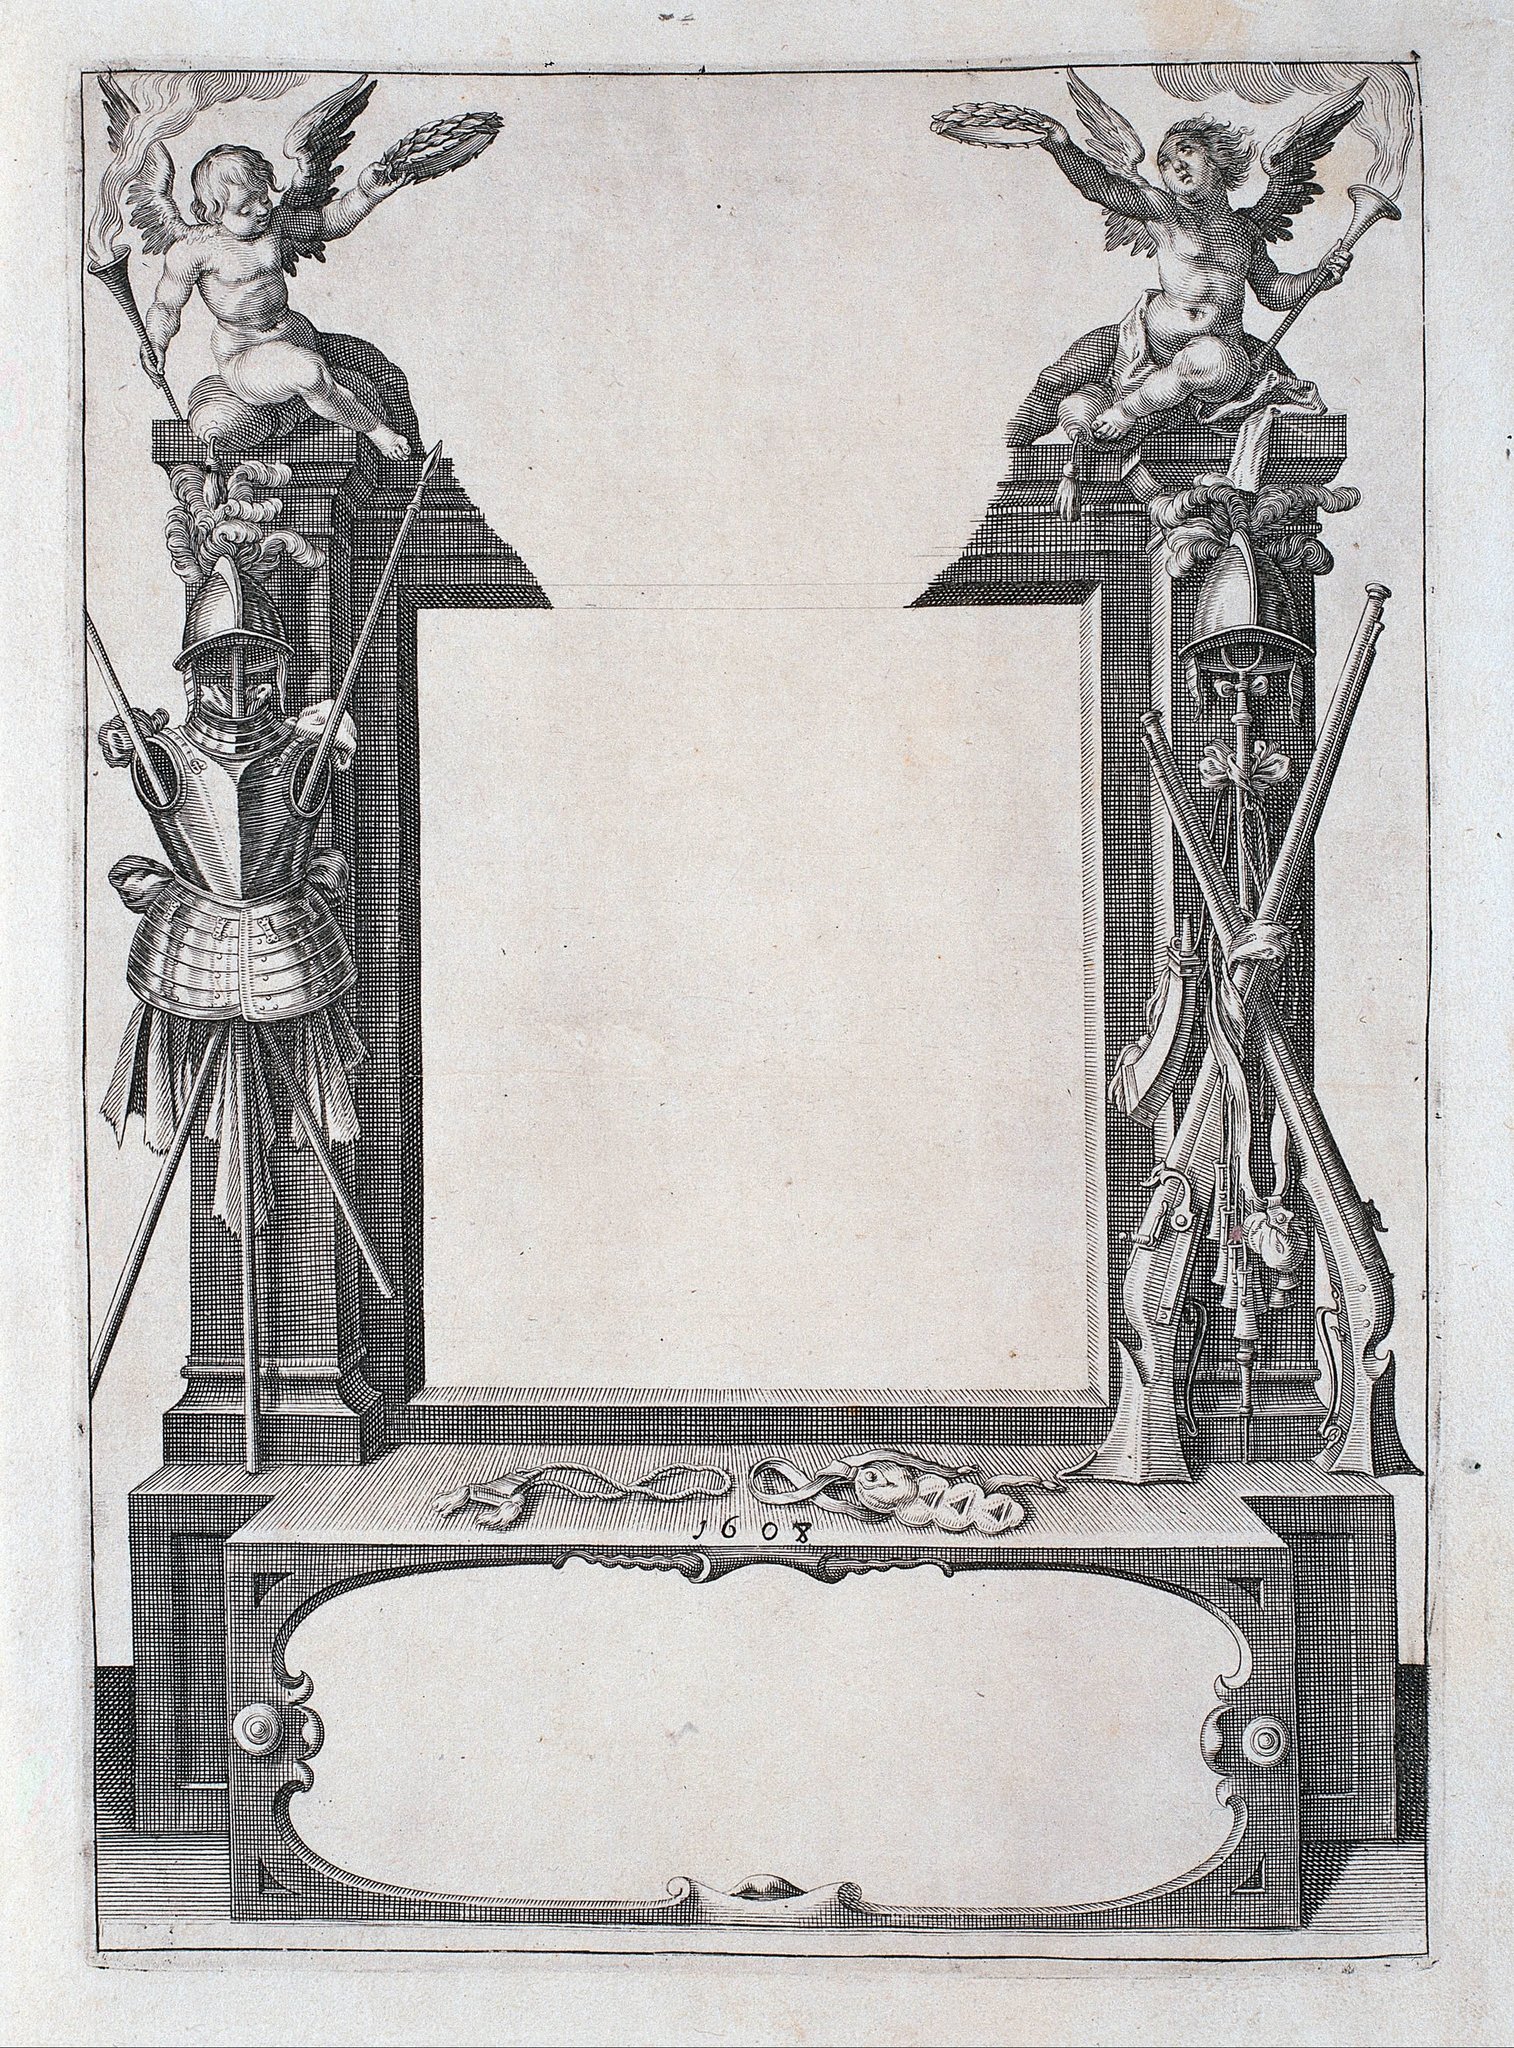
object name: print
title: Wapenhandelinghe van Roers Musquetten ende spiessen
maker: jacques de gheyn (ii)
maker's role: painter, print maker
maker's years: 1565-1629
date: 1607-1608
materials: paper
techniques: engraving, writing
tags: manoeuvre ~ military training, armour, crowning with laurel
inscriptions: date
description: Proefdruk voor het titelblad van de Wapenhandelinghe. Een architecturale omlijsting waarop twee engeltjes zitten, elk met een lauwerkrans in de handen. De ruimte voor wapenschild, titelgegevens en adres binnen de omlijsting is oningevuld. Links een wapenrusting op een standaard, rechts twee geweren. Onderaan de datum 1607, met pen veranderd in 1608. Deze prent (althans de definitieve staat ervan) is het titelblad voor een geheel van drie inleidende teksten en genummerde prentreeksen die het hanteren van het roer, het musket en de spies betreffen.